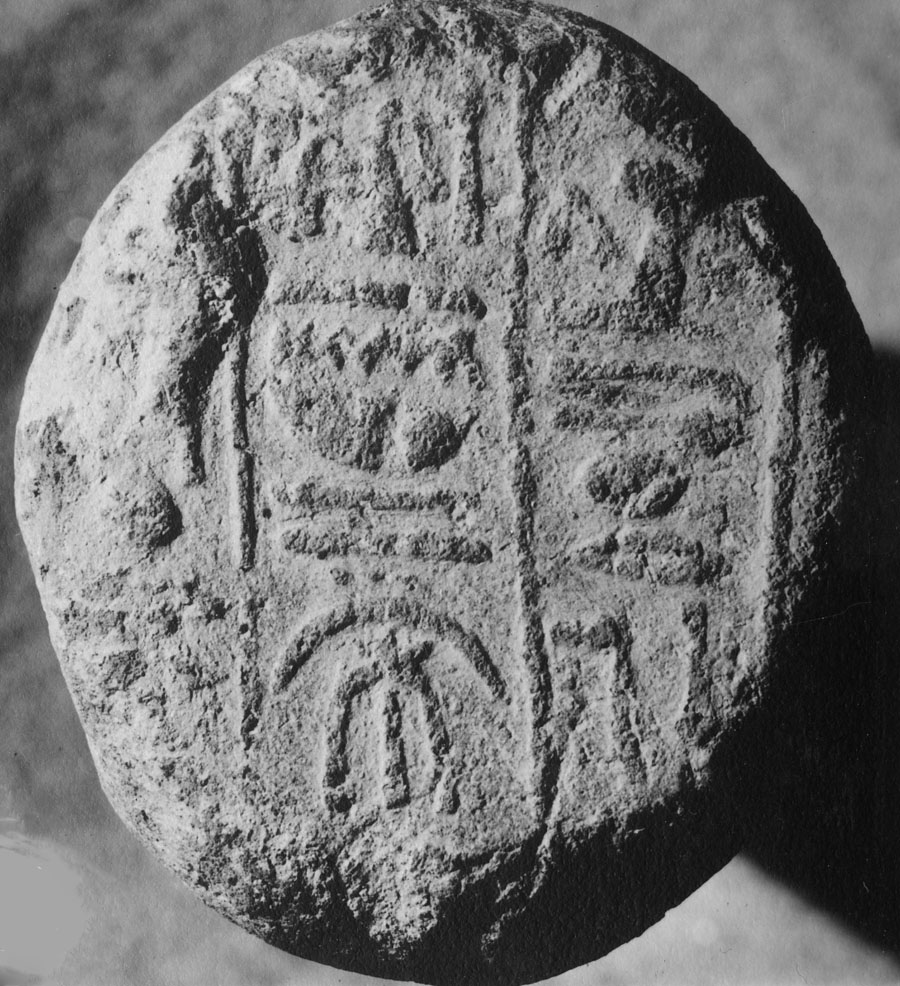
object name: cone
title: Funerary Cone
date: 1550-1295 BCE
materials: pottery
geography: egypt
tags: hieroglyphs